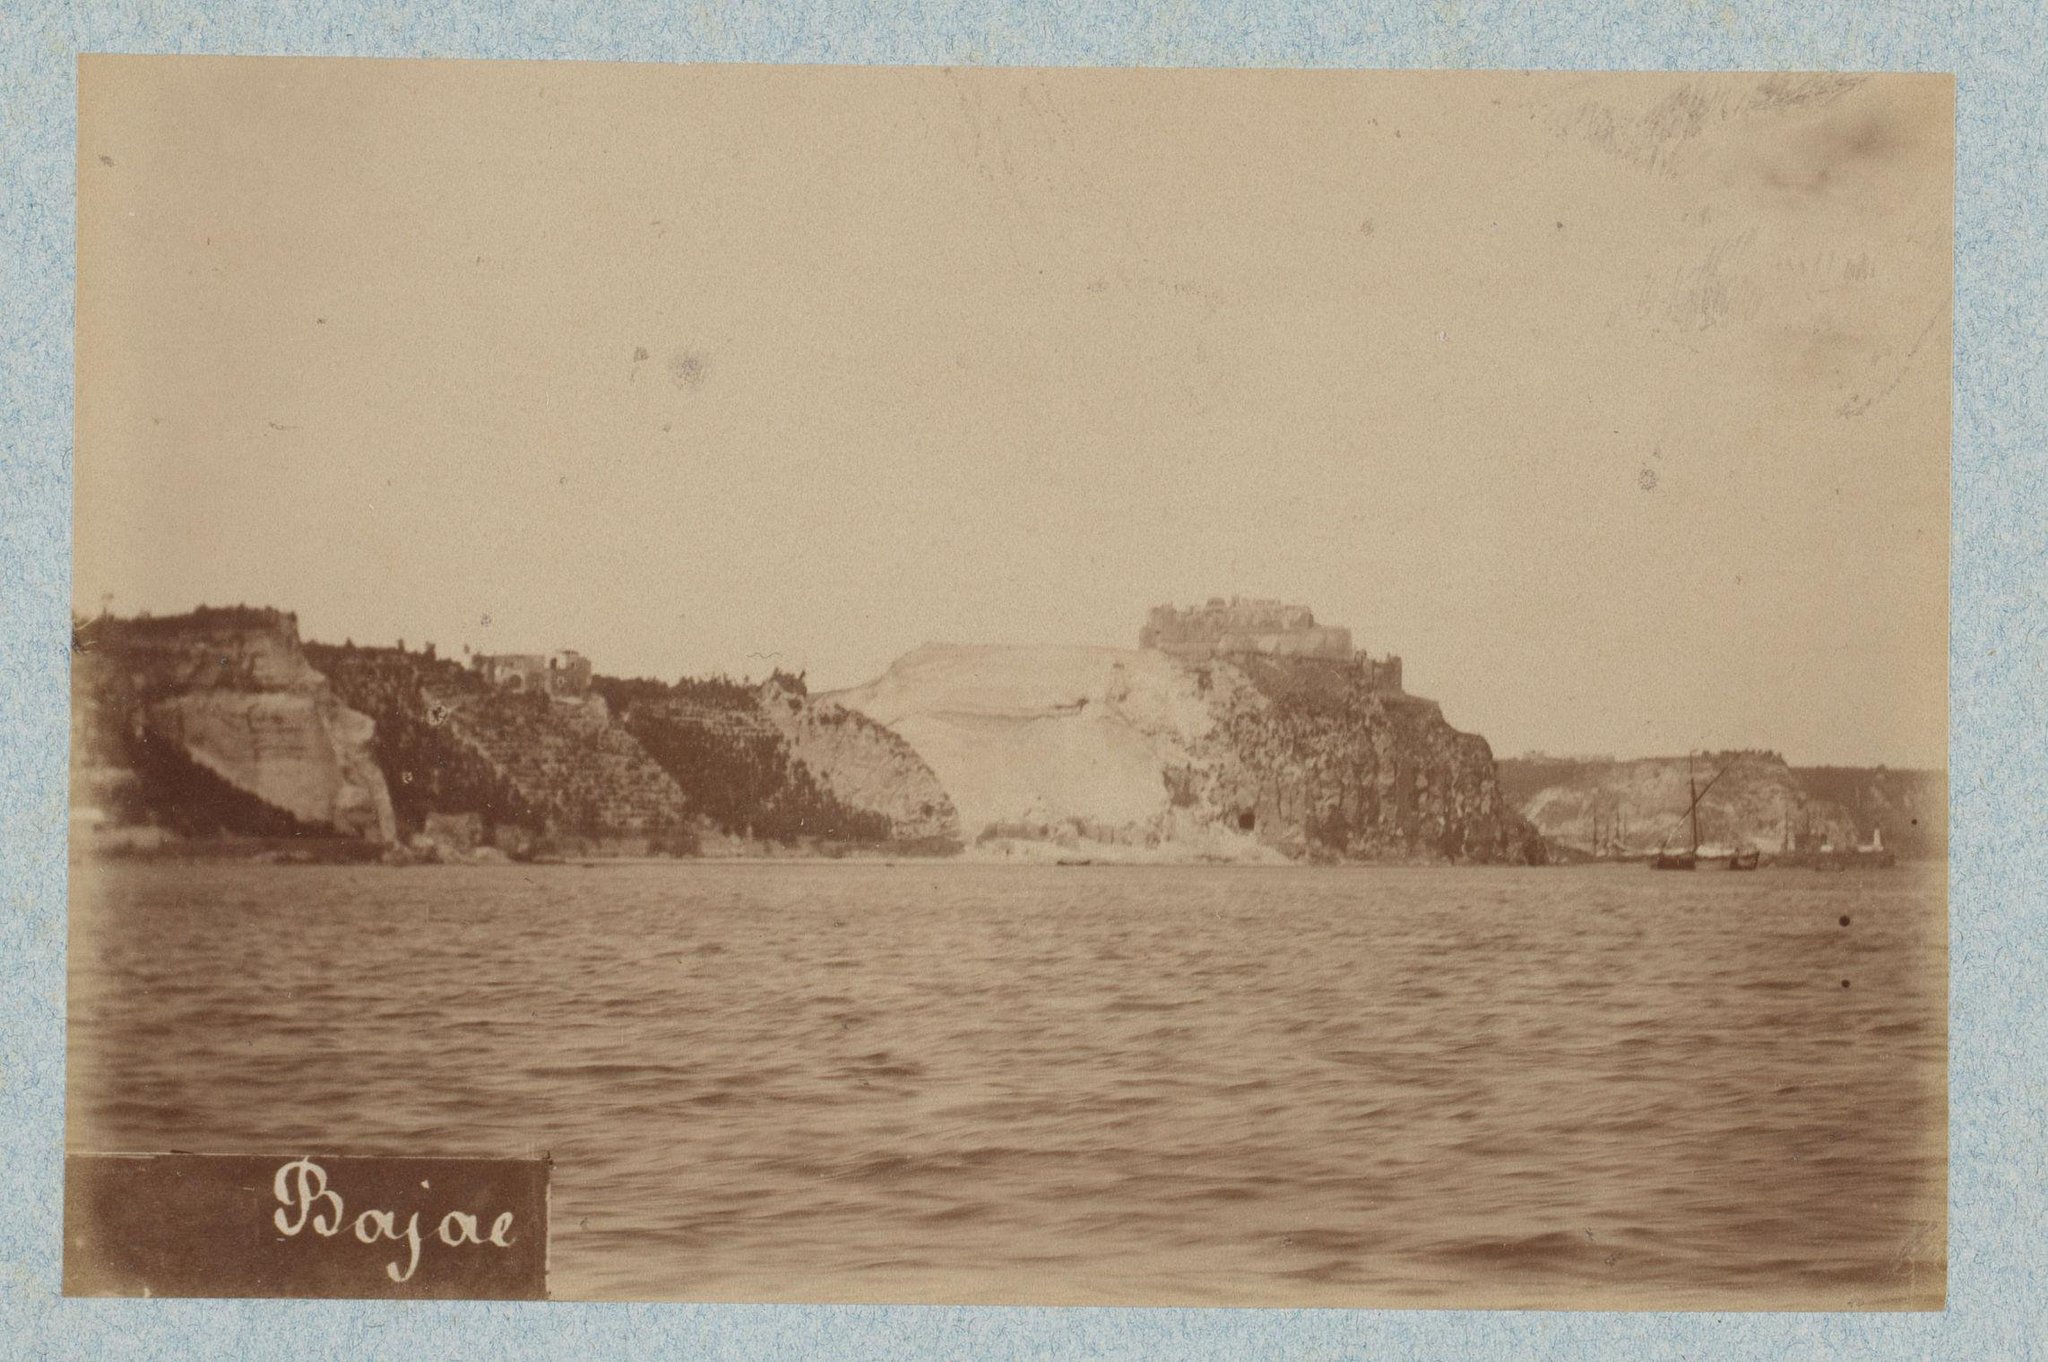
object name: photograph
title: Bajae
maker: Anonymous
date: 1851-1900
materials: cardboard, paper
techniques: albumen print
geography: baia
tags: landscape with ruins, coast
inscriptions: collector's mark: ‘VOSMAER’